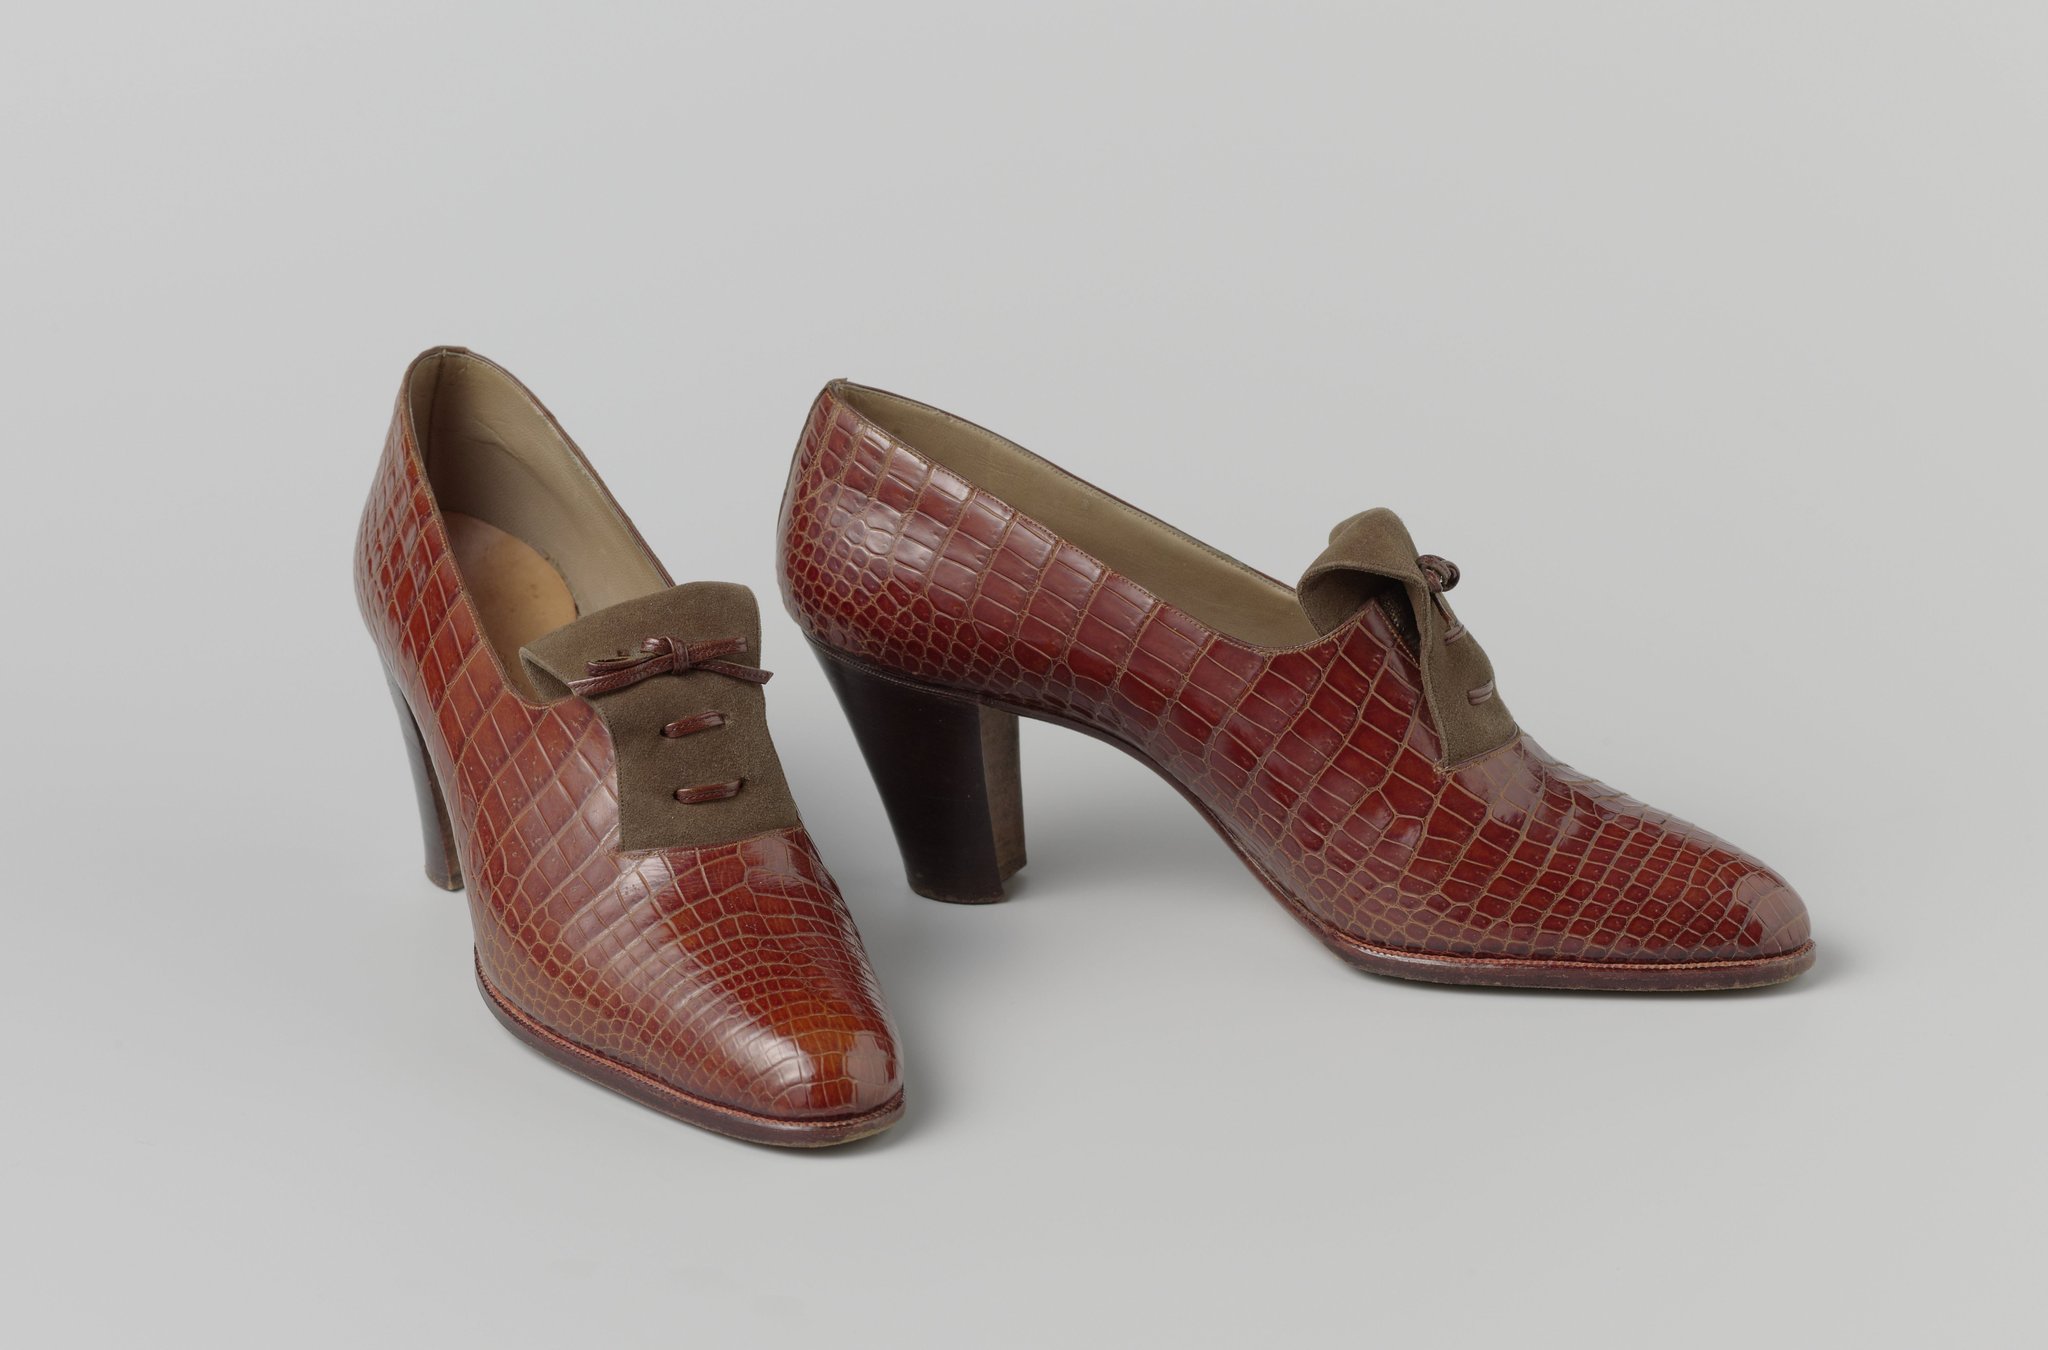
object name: womenswear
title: Schoen van roodbruin slangenleer met een tong van bruin suède met een geregen en gestrikte leren veter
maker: a. van goethem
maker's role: schoenmaker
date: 1930-1940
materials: leather, skin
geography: brussels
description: Linkerschoen van roodbruin slangenleer met een tong van bruin suède met een geregen en gestrikte leren veter. Model: instapper met hoge, rechte hak (7 cm). Op de wreef een elastieken band voor gemakkelijke instap. Gevoerd met leverkleurig leer. Binnenzool van naturelkleurig leer met gouden opdruk. Leren zool en hak. Versiering: ter camouflage van de elastieken band is over de wreef een tong van dubbel gestikt suède aangebracht die uit een 5 cm brede halfronde snee in het voorblad komt en in de instap verdwijnt. De tong is versierd met een leren veter die door het suède is geregen en bovenop gestrikt. De naad aan de hiel is gecamoufleerd door een extra strook slangenleer. Adres (op de binnenzool): A.VAN GOETHEM 15 RUE DE NAMUR/PRES LA PLACE ROYALE BRUXELLES.Opmerking: op de voering van de linkerschoen is met ballpoint geschreven: 120268/3091.